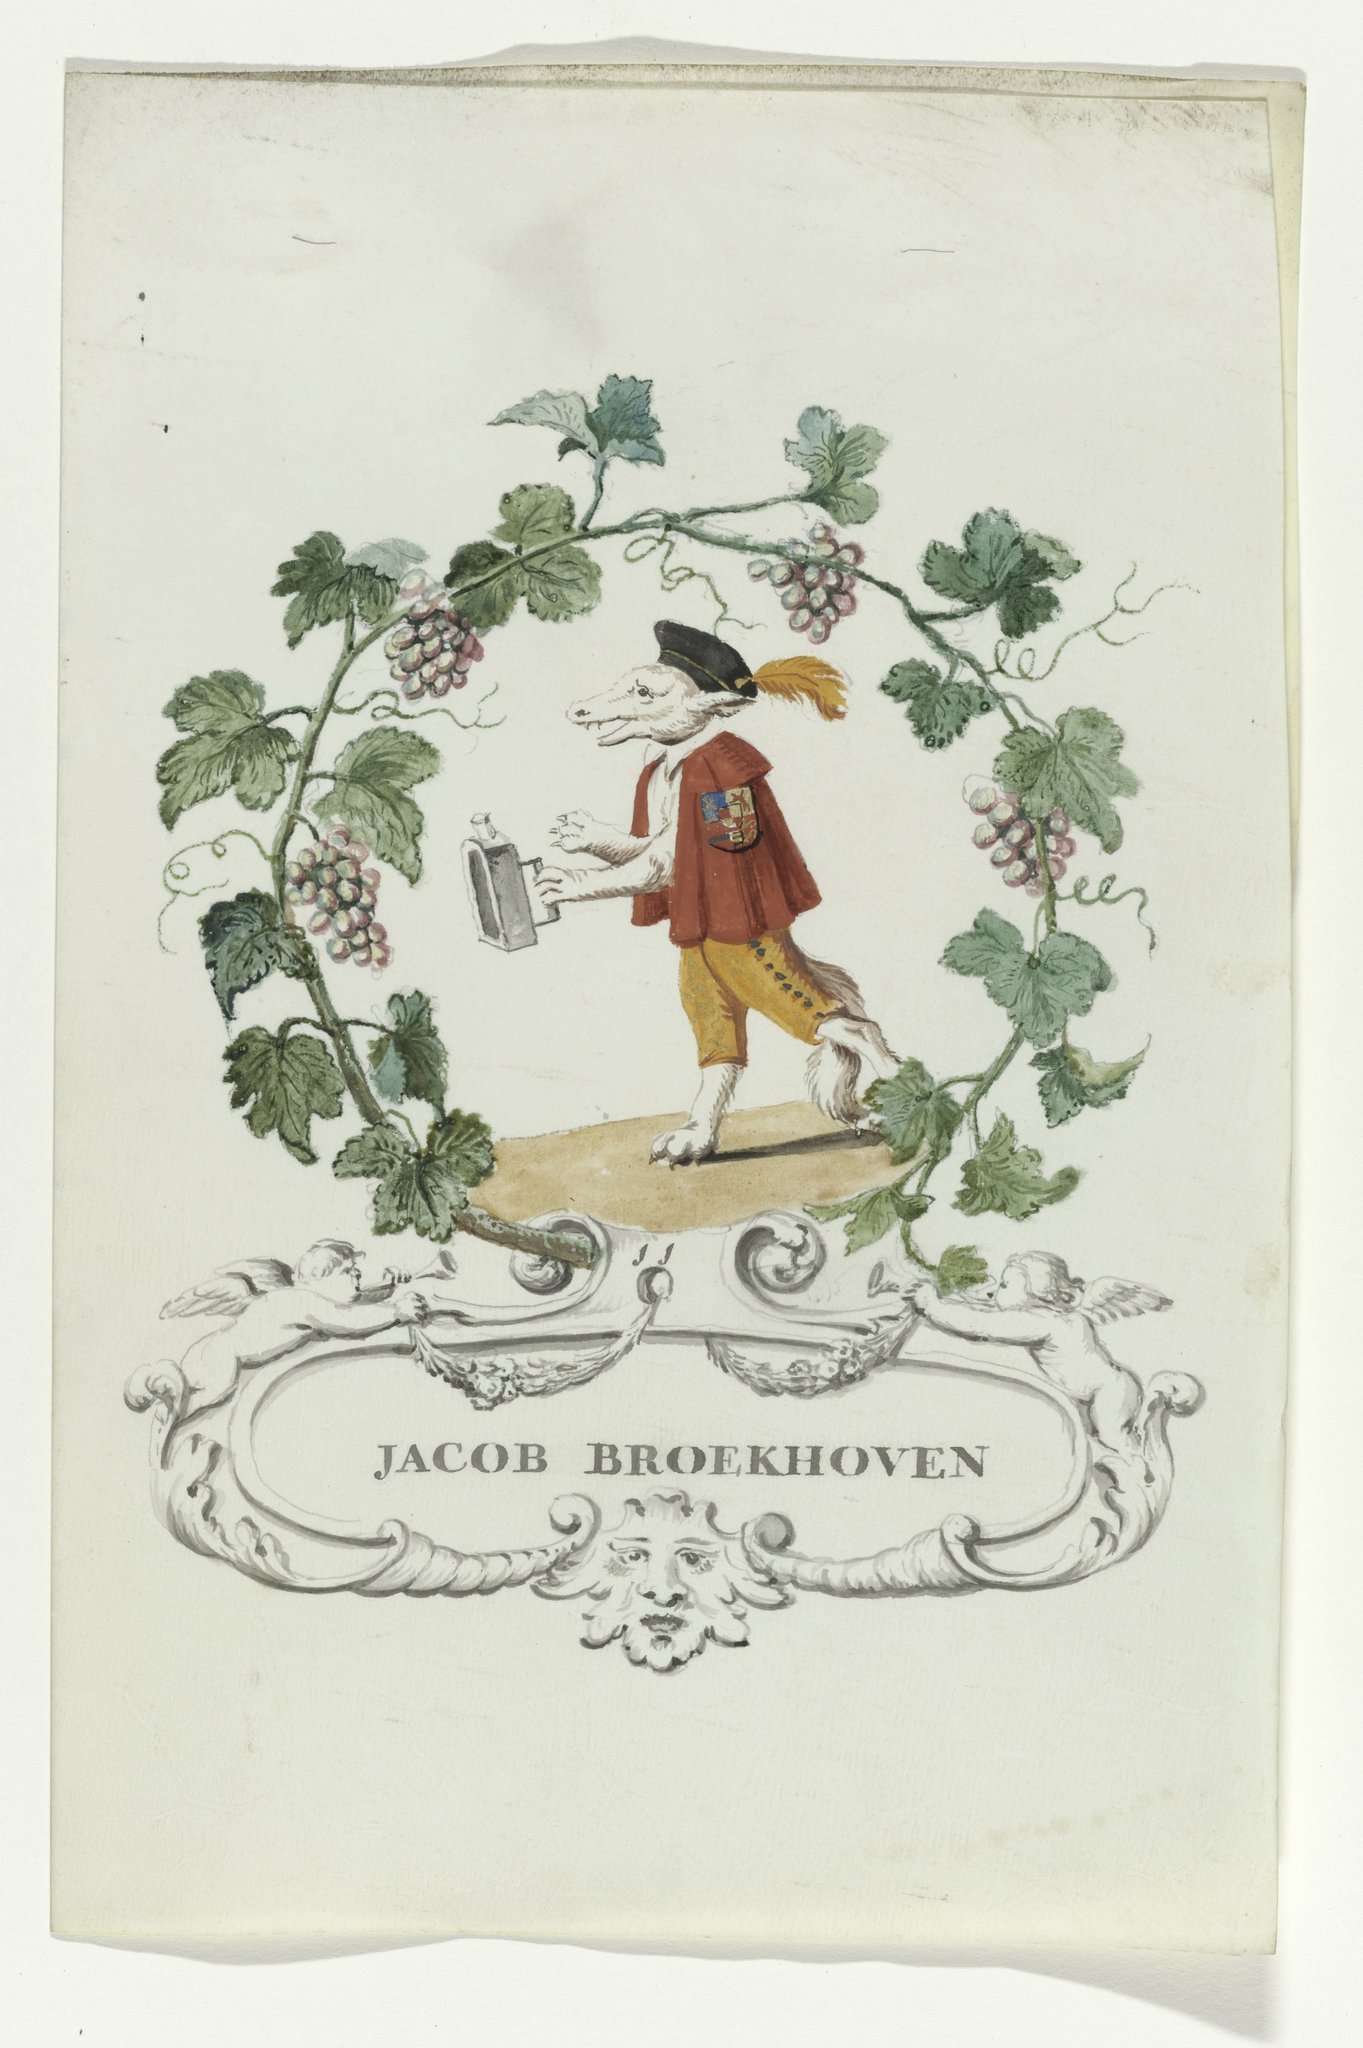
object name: drawing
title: Regtspleging van Oldenbarnevelt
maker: Anonymous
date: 1710-1720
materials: ink, parchment, watercolor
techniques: brush, pen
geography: netherlands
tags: the hague, johan van oldenbarnevelt, leiden, caricatures (human types), bad, corrupt judge, political caricatures and satires, beasts of prey, predatory animals: fox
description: Spotprent van Jacob Broekhoven, rechter van Van Oldenbarnevelt; vos met oranje kniebroek, manteltje waarop wapen en bonnet met oranje pluim, in krans van druivenranken. Daaronder cartouche met aan weerszijden twee trompetblazende putti. In cartouche naam en daarboven nr. 11. Behorende bij serie aquarellen in boek.